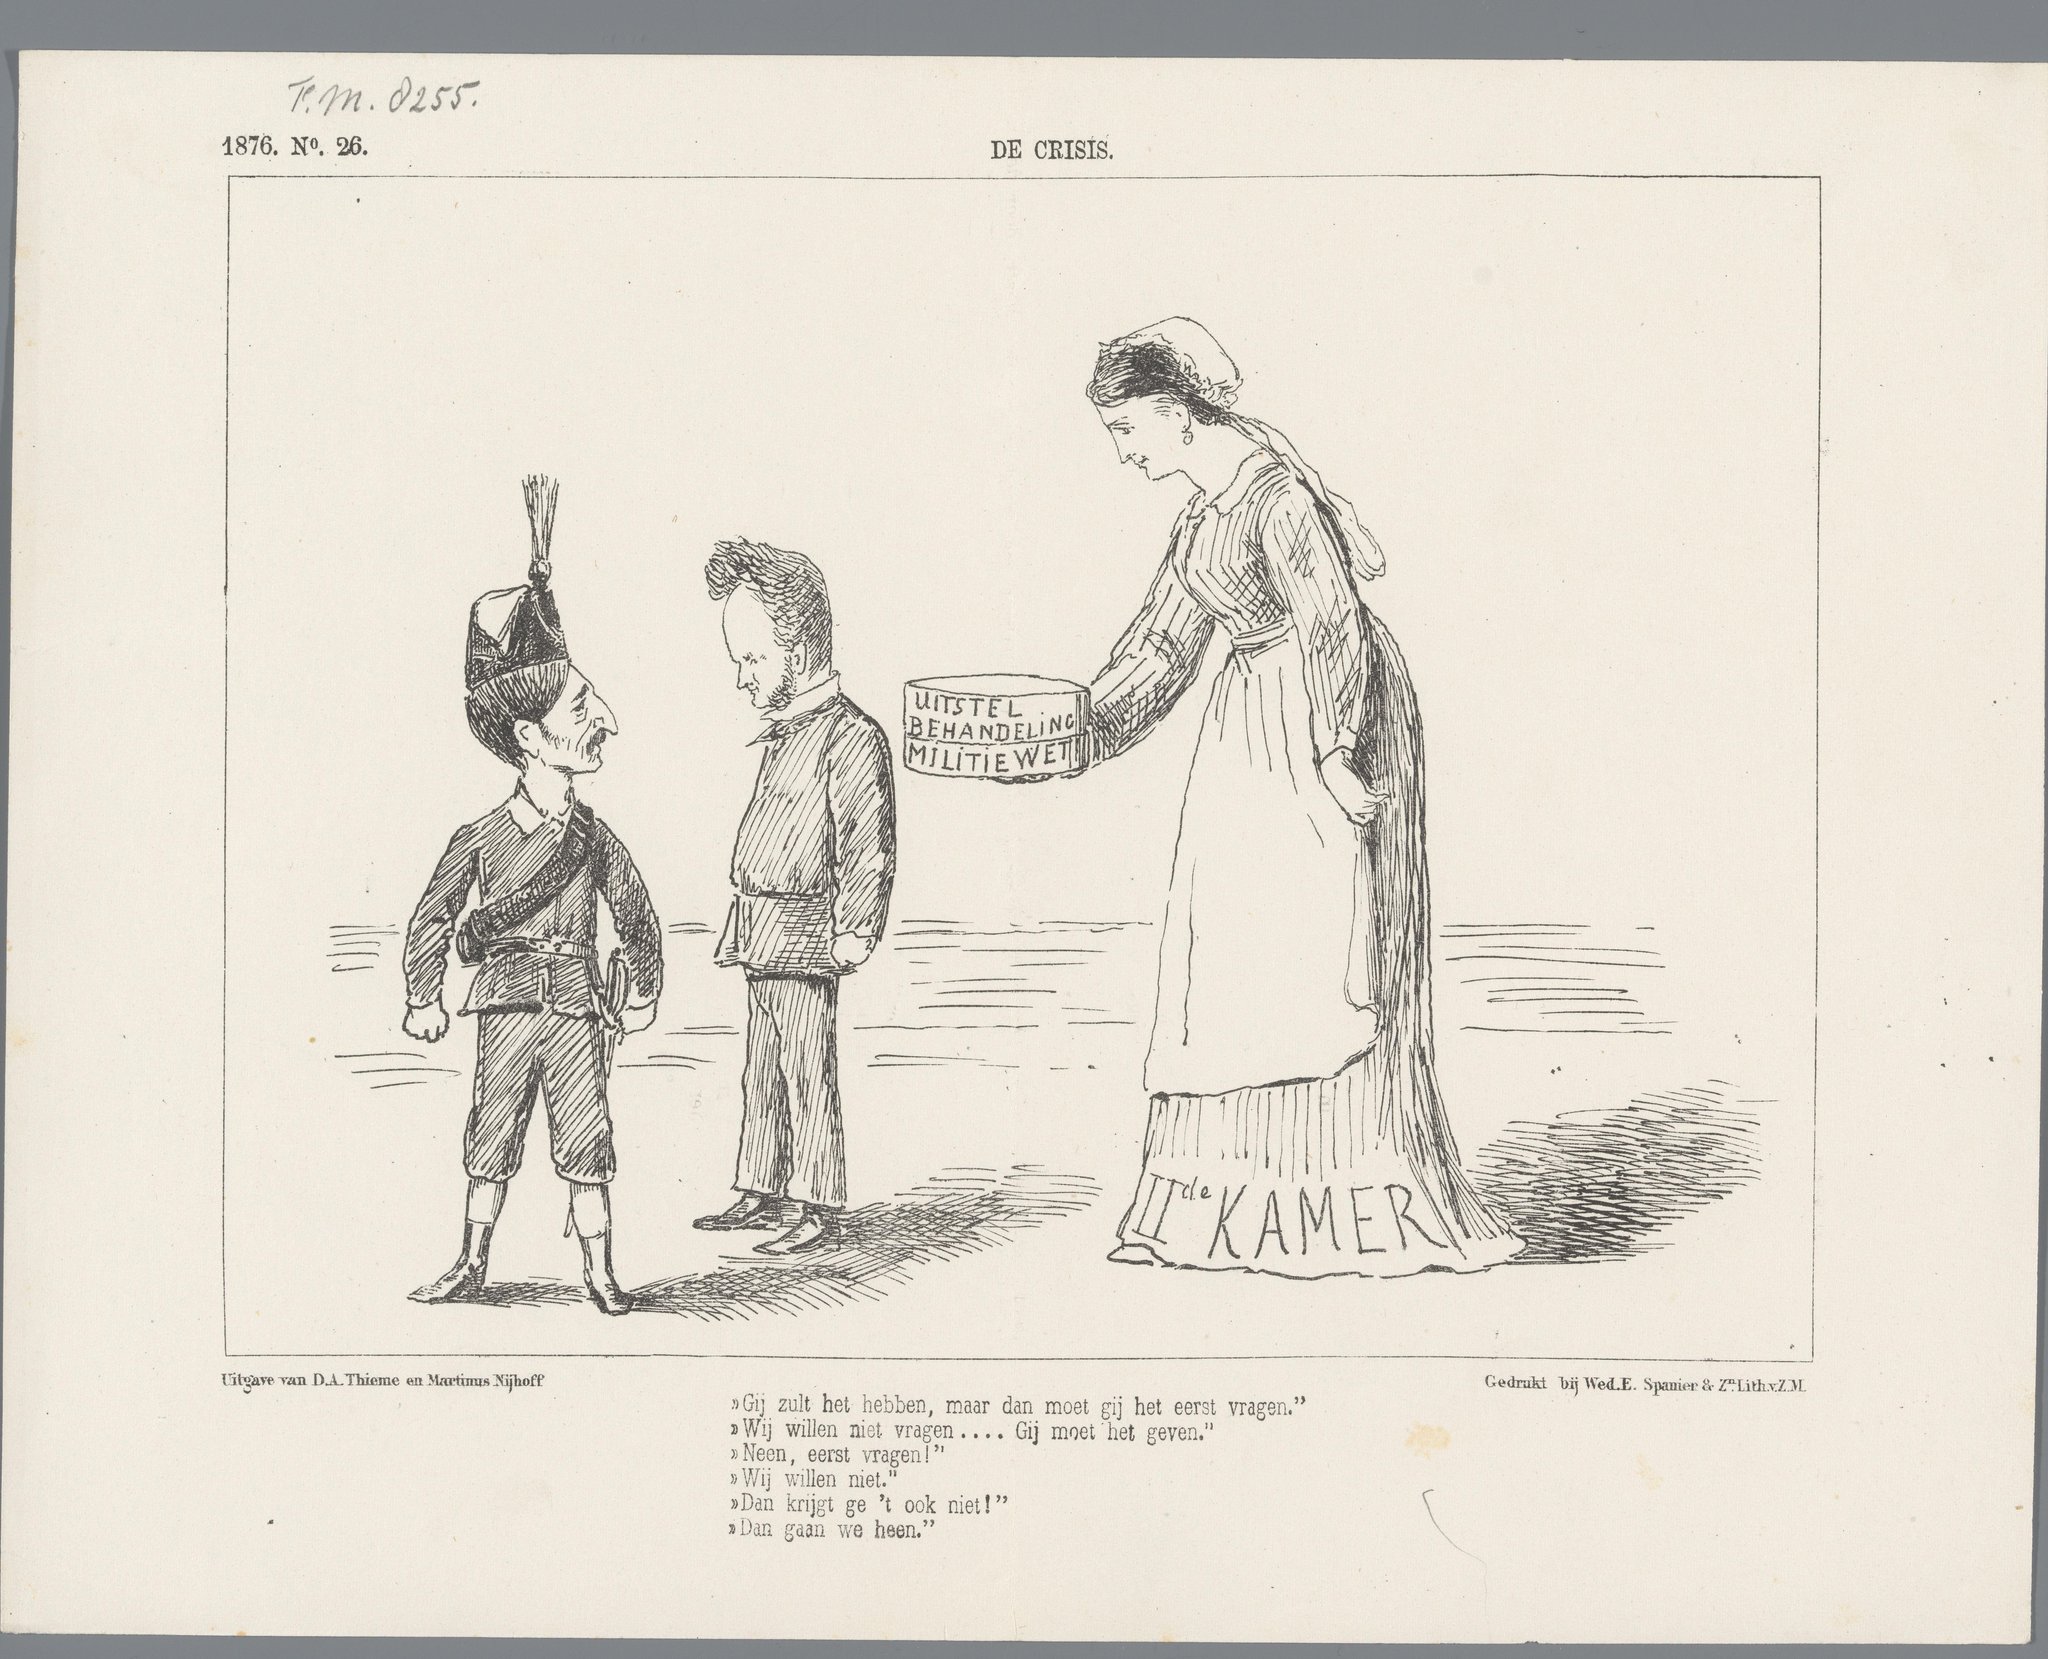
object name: print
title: Standbeeld van Willem II, koning der Nederlanden, op het Buitenhof te Den Haag, 1854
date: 1854-1899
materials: paper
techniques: lithograph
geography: netherlands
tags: the hague, william ii of the netherlands, monument, statue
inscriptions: collector's mark: Lugt 2228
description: Standbeeld van Willem II door E.F. Georges op het Buitenhof te Den Haag. Onthuld op 23 maart 1854. Geheel in een geornamenteerde rechthoek.